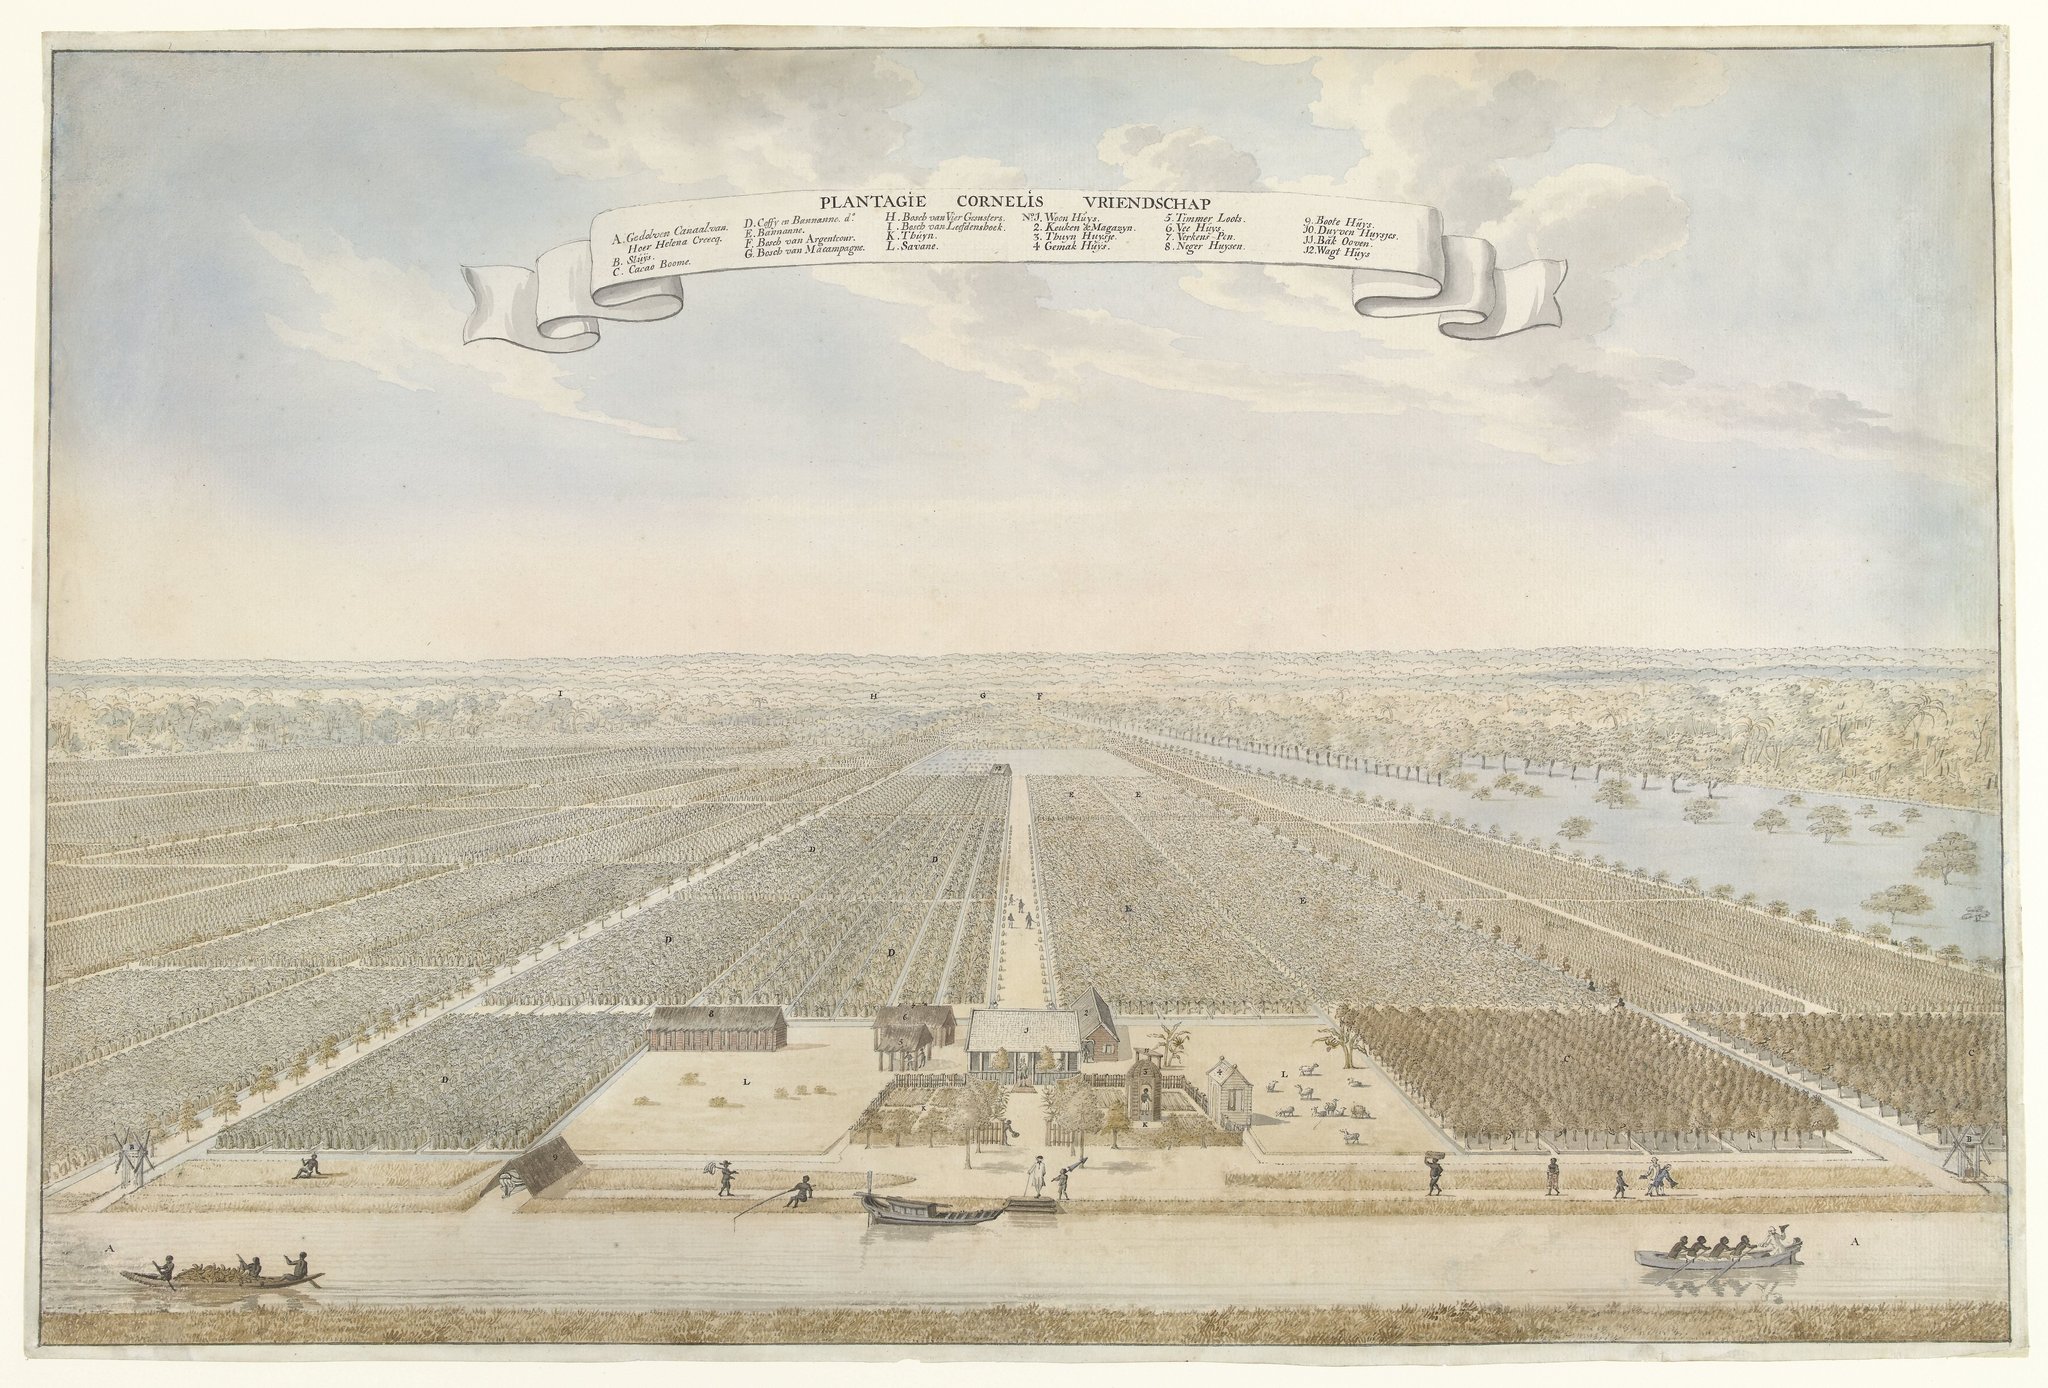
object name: watercolor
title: Gezicht op de plantage Cornelis Vriendschap in Suriname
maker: Anonymous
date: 1700-1800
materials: ink, paper, pencil, watercolor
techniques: brush, pen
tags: plantation, coffee, chocolate, cocoa, fruits: banana, tropical culture, suriname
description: Gezicht op de plantage Cornelis Vriendschap in Suriname; met verklarende lijst.